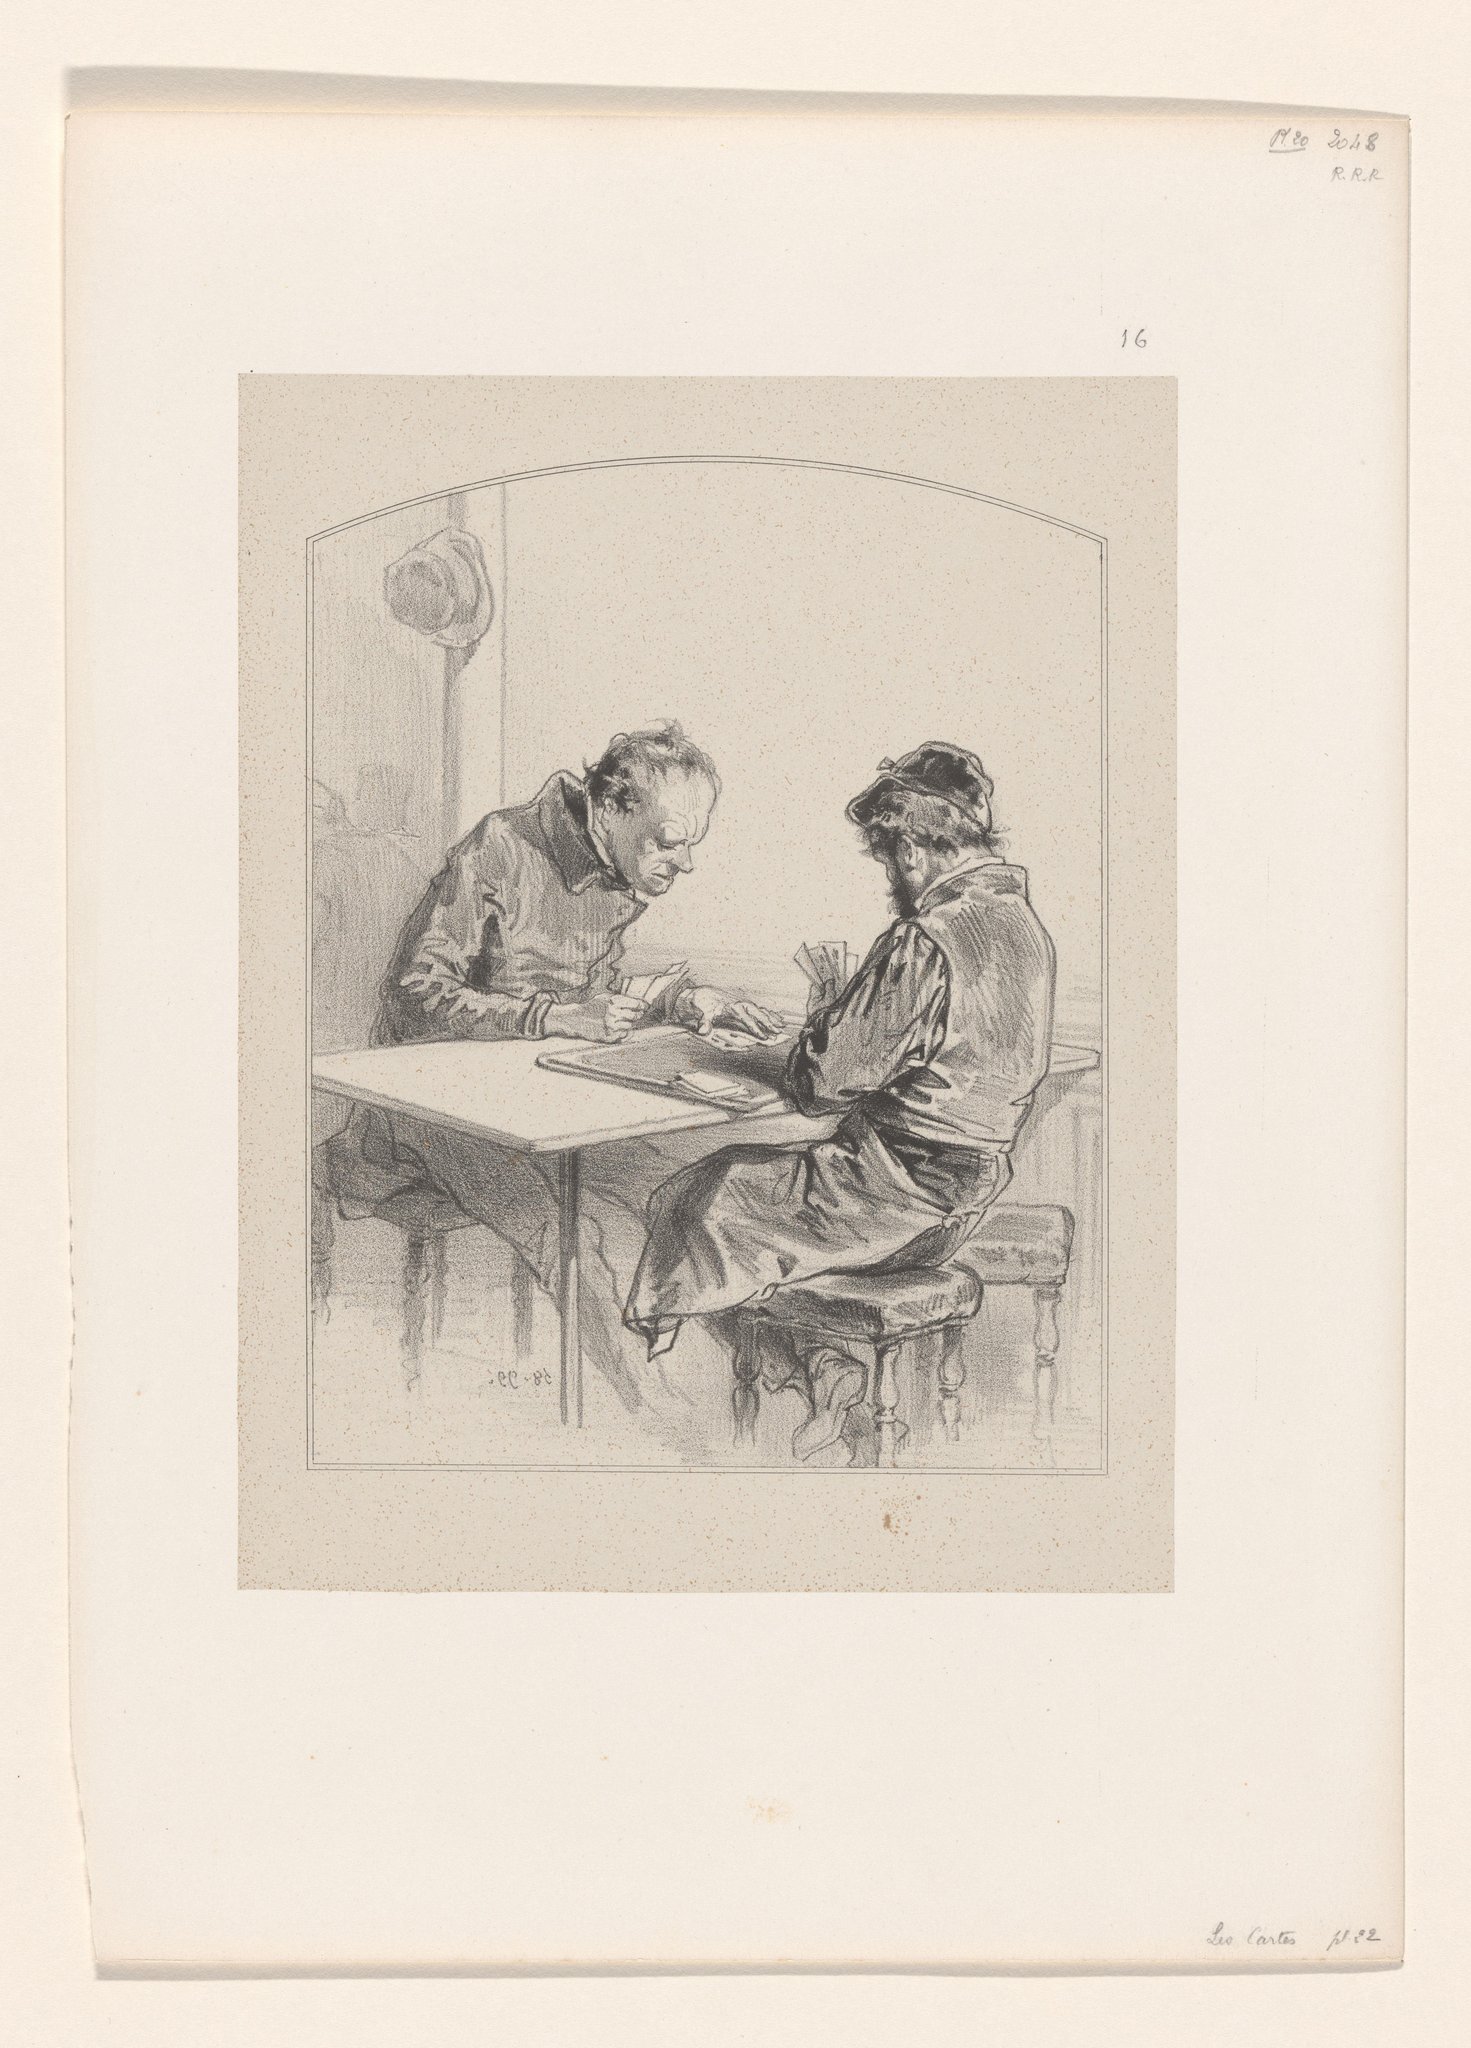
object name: print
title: Les Toquades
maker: paul gavarni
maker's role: draughtsman, print maker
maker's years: 1804-1866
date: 1858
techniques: printmaking, lithograph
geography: paris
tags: inn, coffee-house, public house, etc., card games, card games (+ sportsman, player, etc.)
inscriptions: collector's mark: Lugt 2760, collector's mark: Lugt 2228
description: Twee mannen spelen in een café een kaartspel. Twintigste plaat in een serie van 20 platen verschenen in 1858 onder de titel 'Les Toquades'.